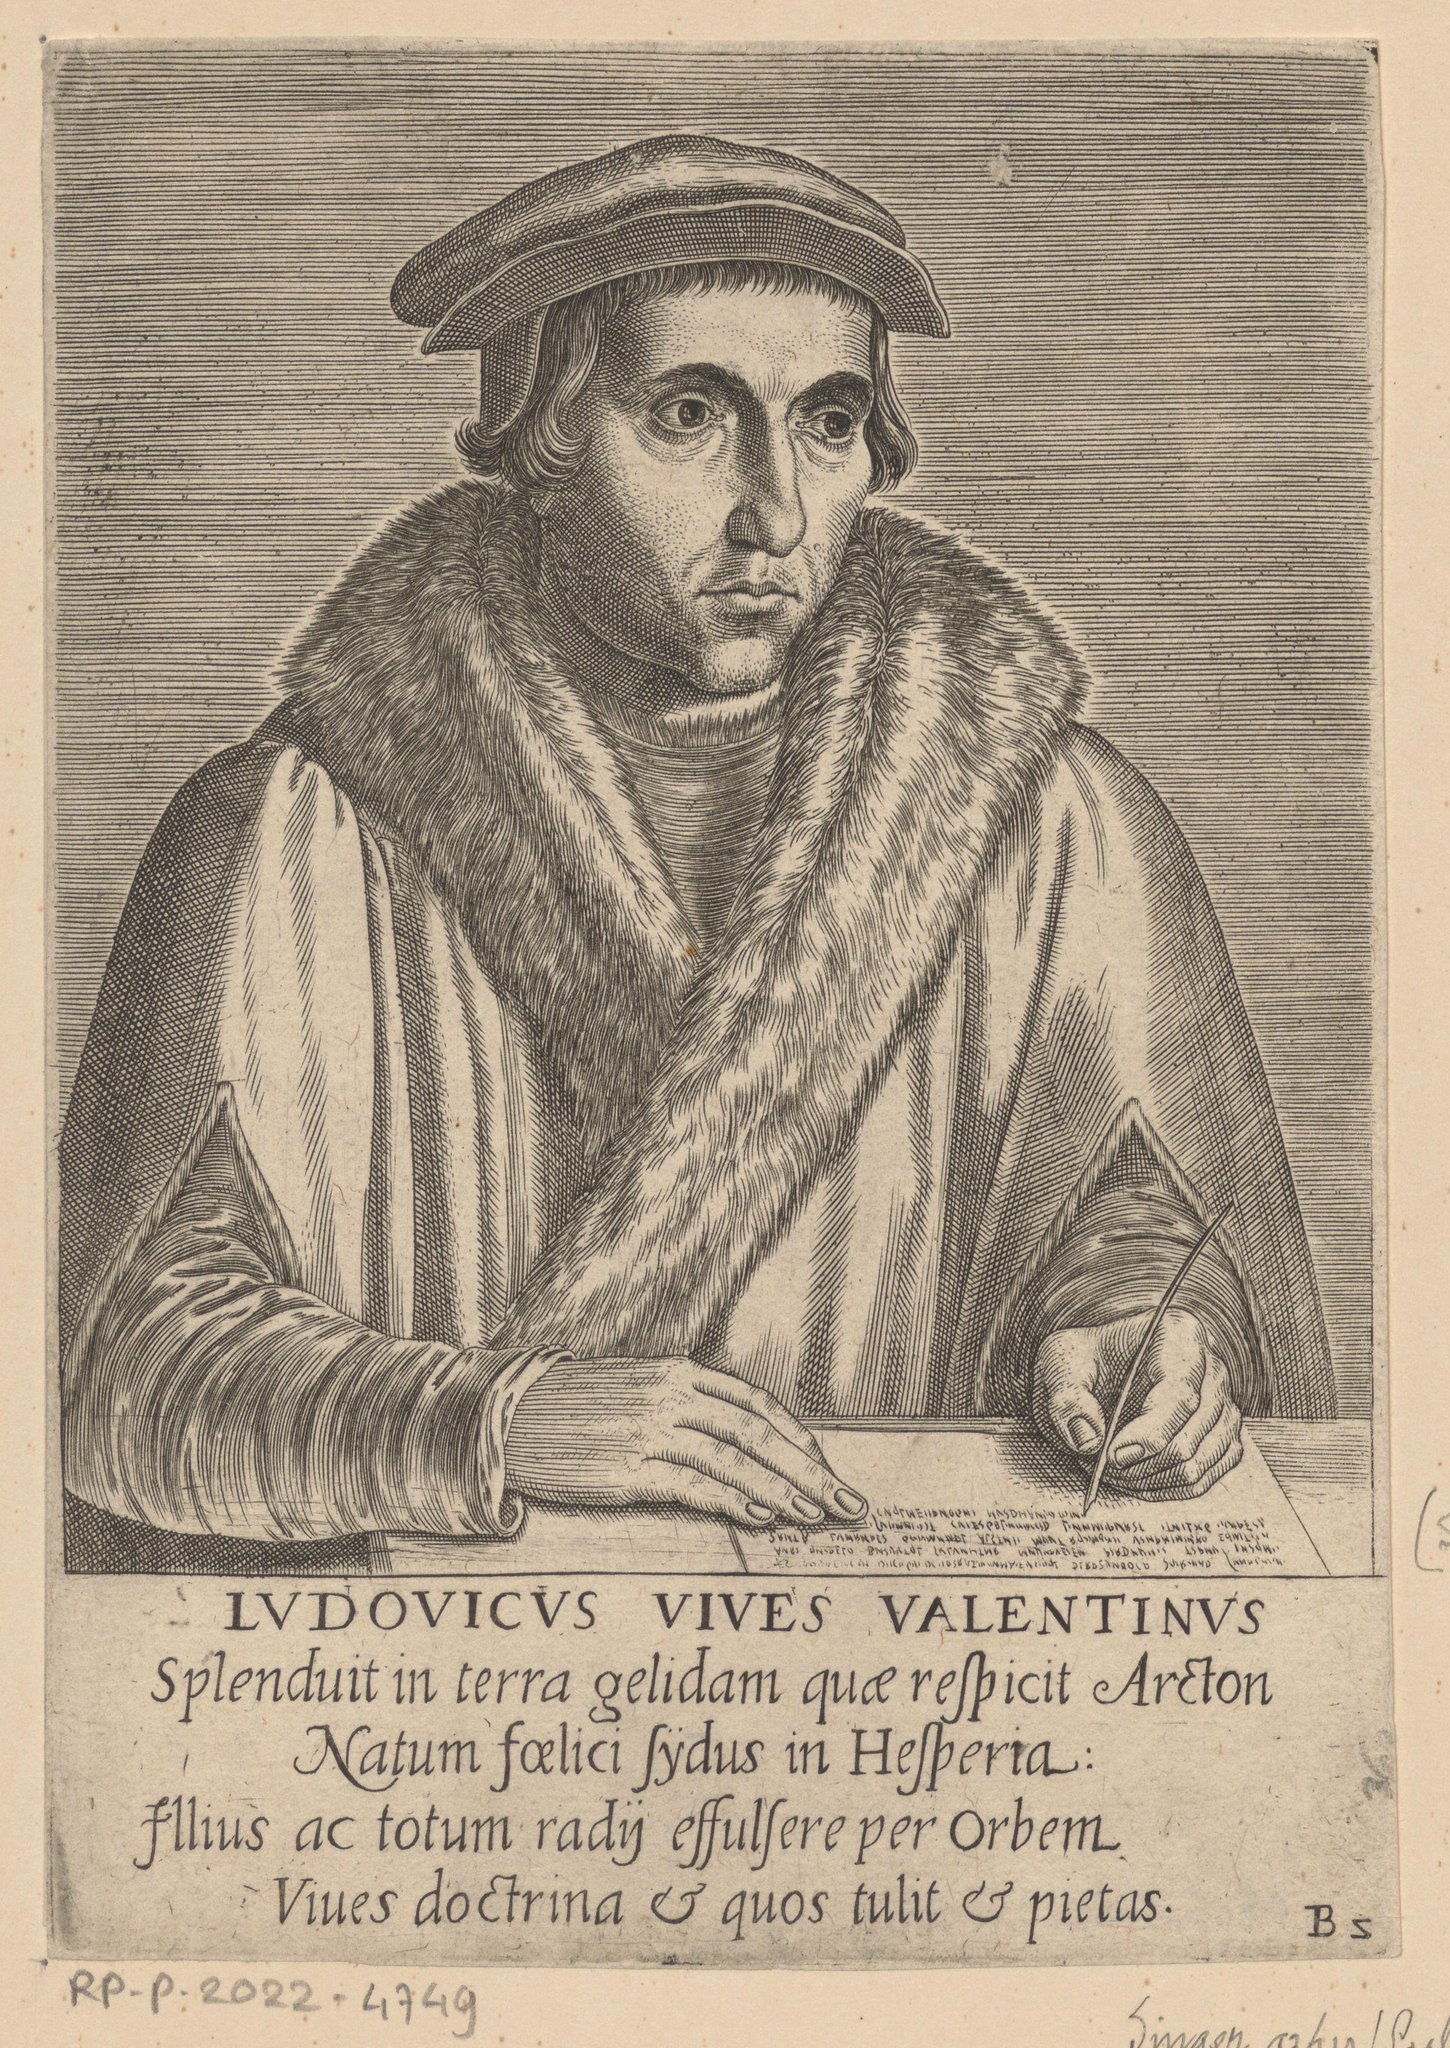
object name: print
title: Ludovicus Vives Valanetinus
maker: philips galle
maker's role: print maker, publisher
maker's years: 1537-1612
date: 1572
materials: paper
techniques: engraving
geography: antwerp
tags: bruges, handwriting, writing as activity, scholar, philosopher, historical persons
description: Met vierregelig onderschrift in het Latijn. Rechtsonder genummerd: B2 (2 als z in spiegelbeeld).